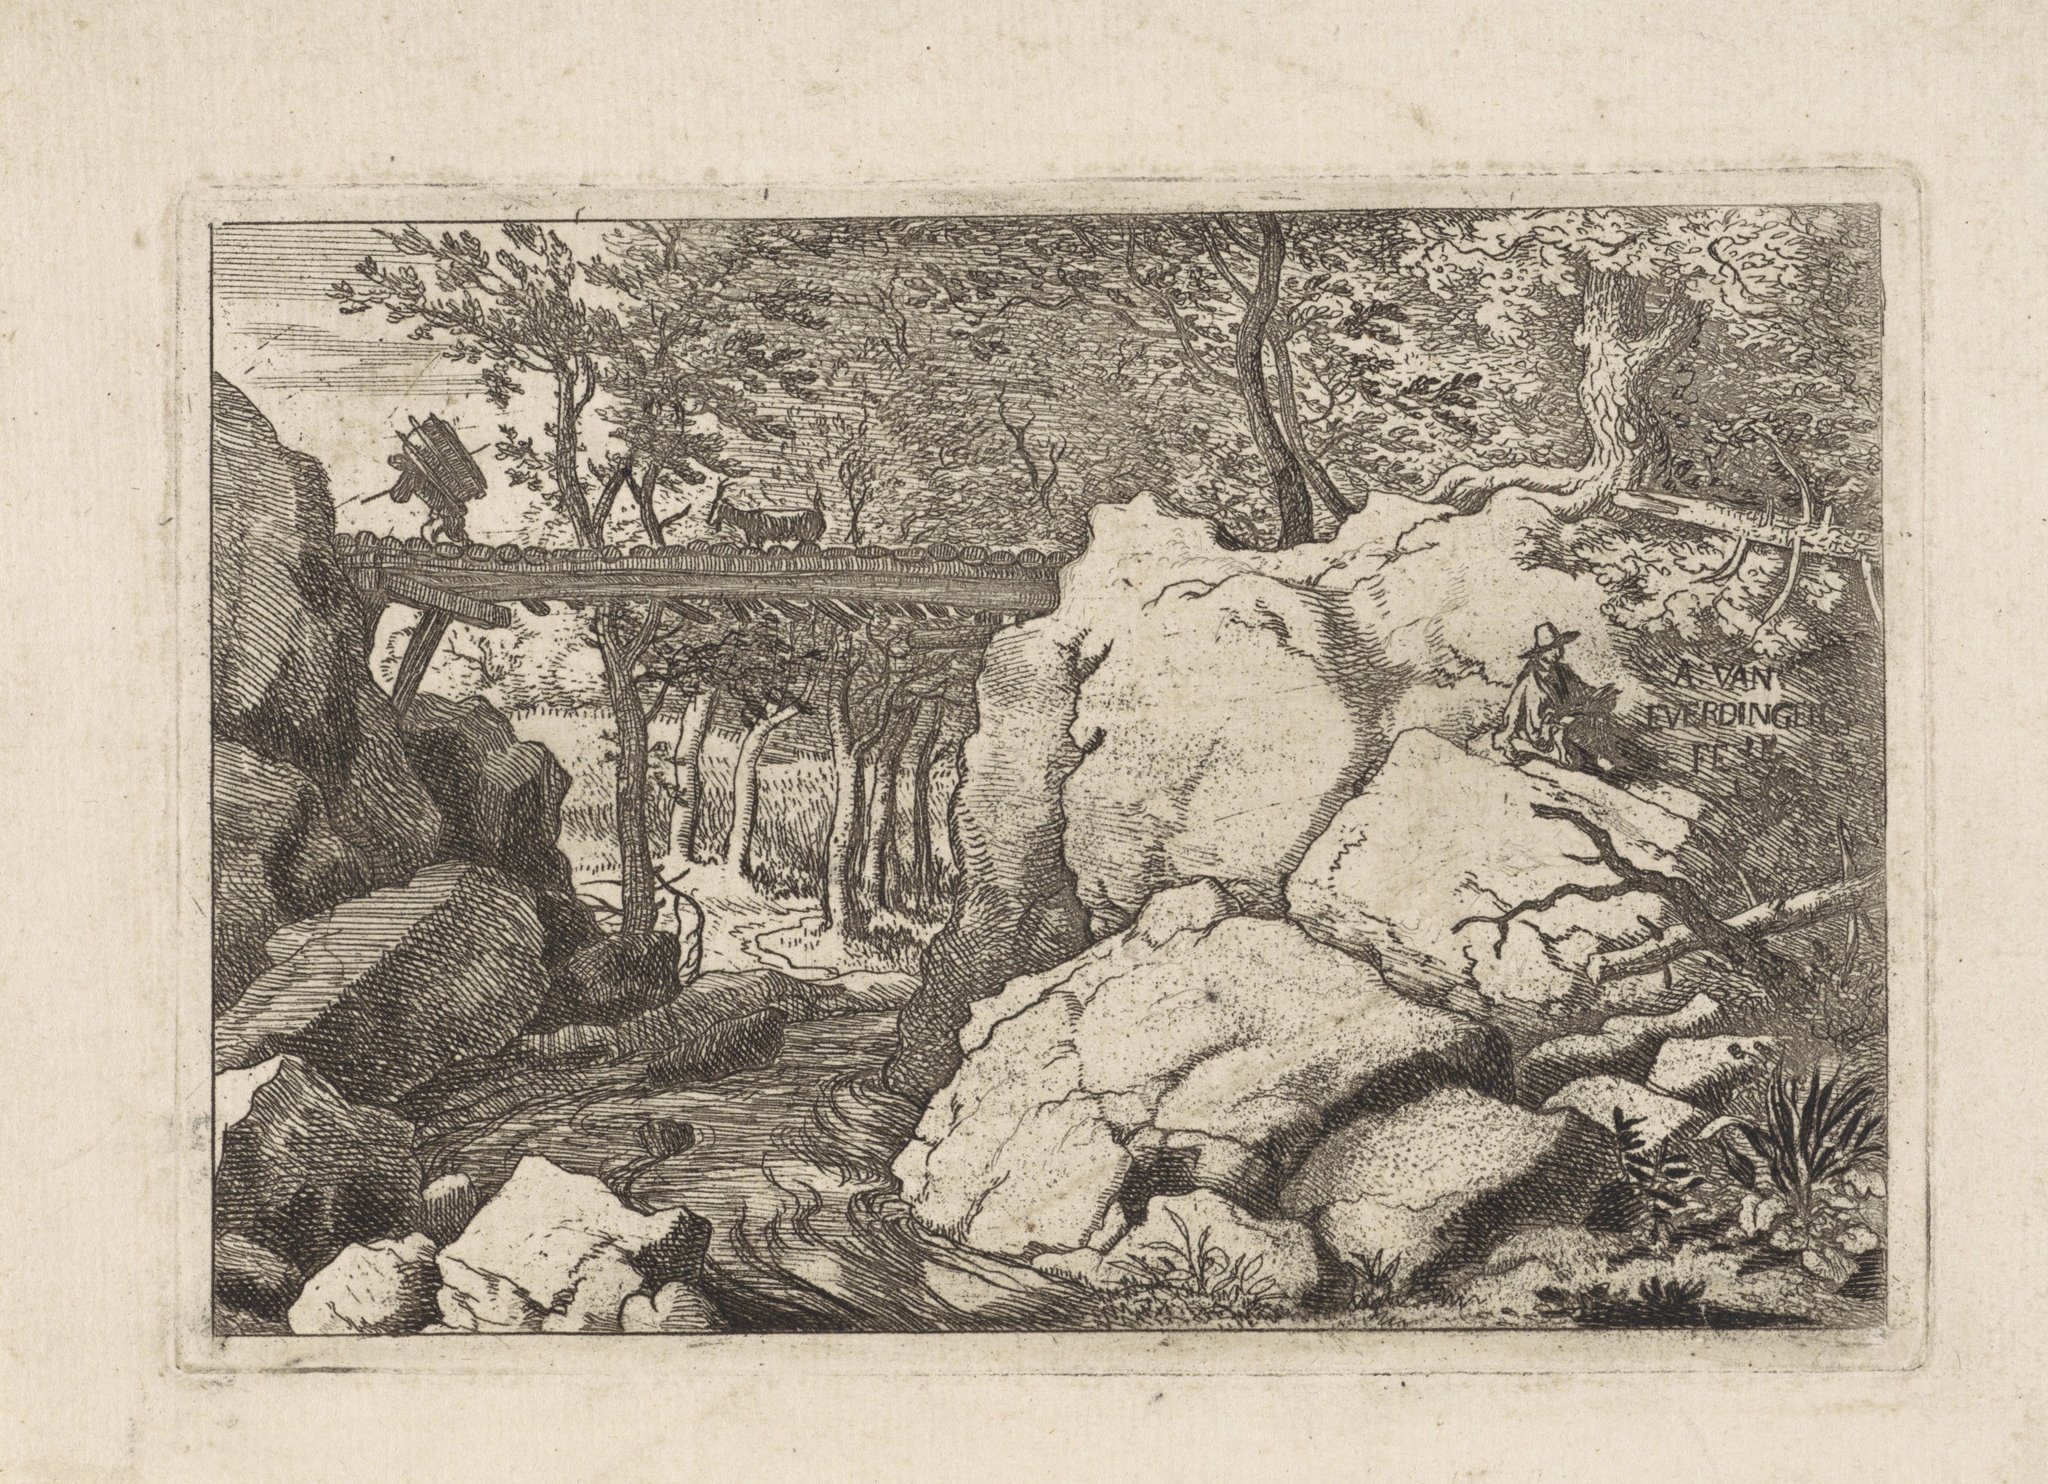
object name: print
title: Landschap met geit op brug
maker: allaert van everdingen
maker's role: draughtsman, painter, print maker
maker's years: 1621-1675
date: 1631-1675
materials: paper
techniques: etching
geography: netherlands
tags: landscape with bridge, viaduct or aqueduct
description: Bosachtig landschap met hoge rotspartijen aan weerszijden van een beek. Over het water een houten brug waar een geit en een man met een mand op zijn rug lopen. Een tweede persoon zit op een rotsblok.